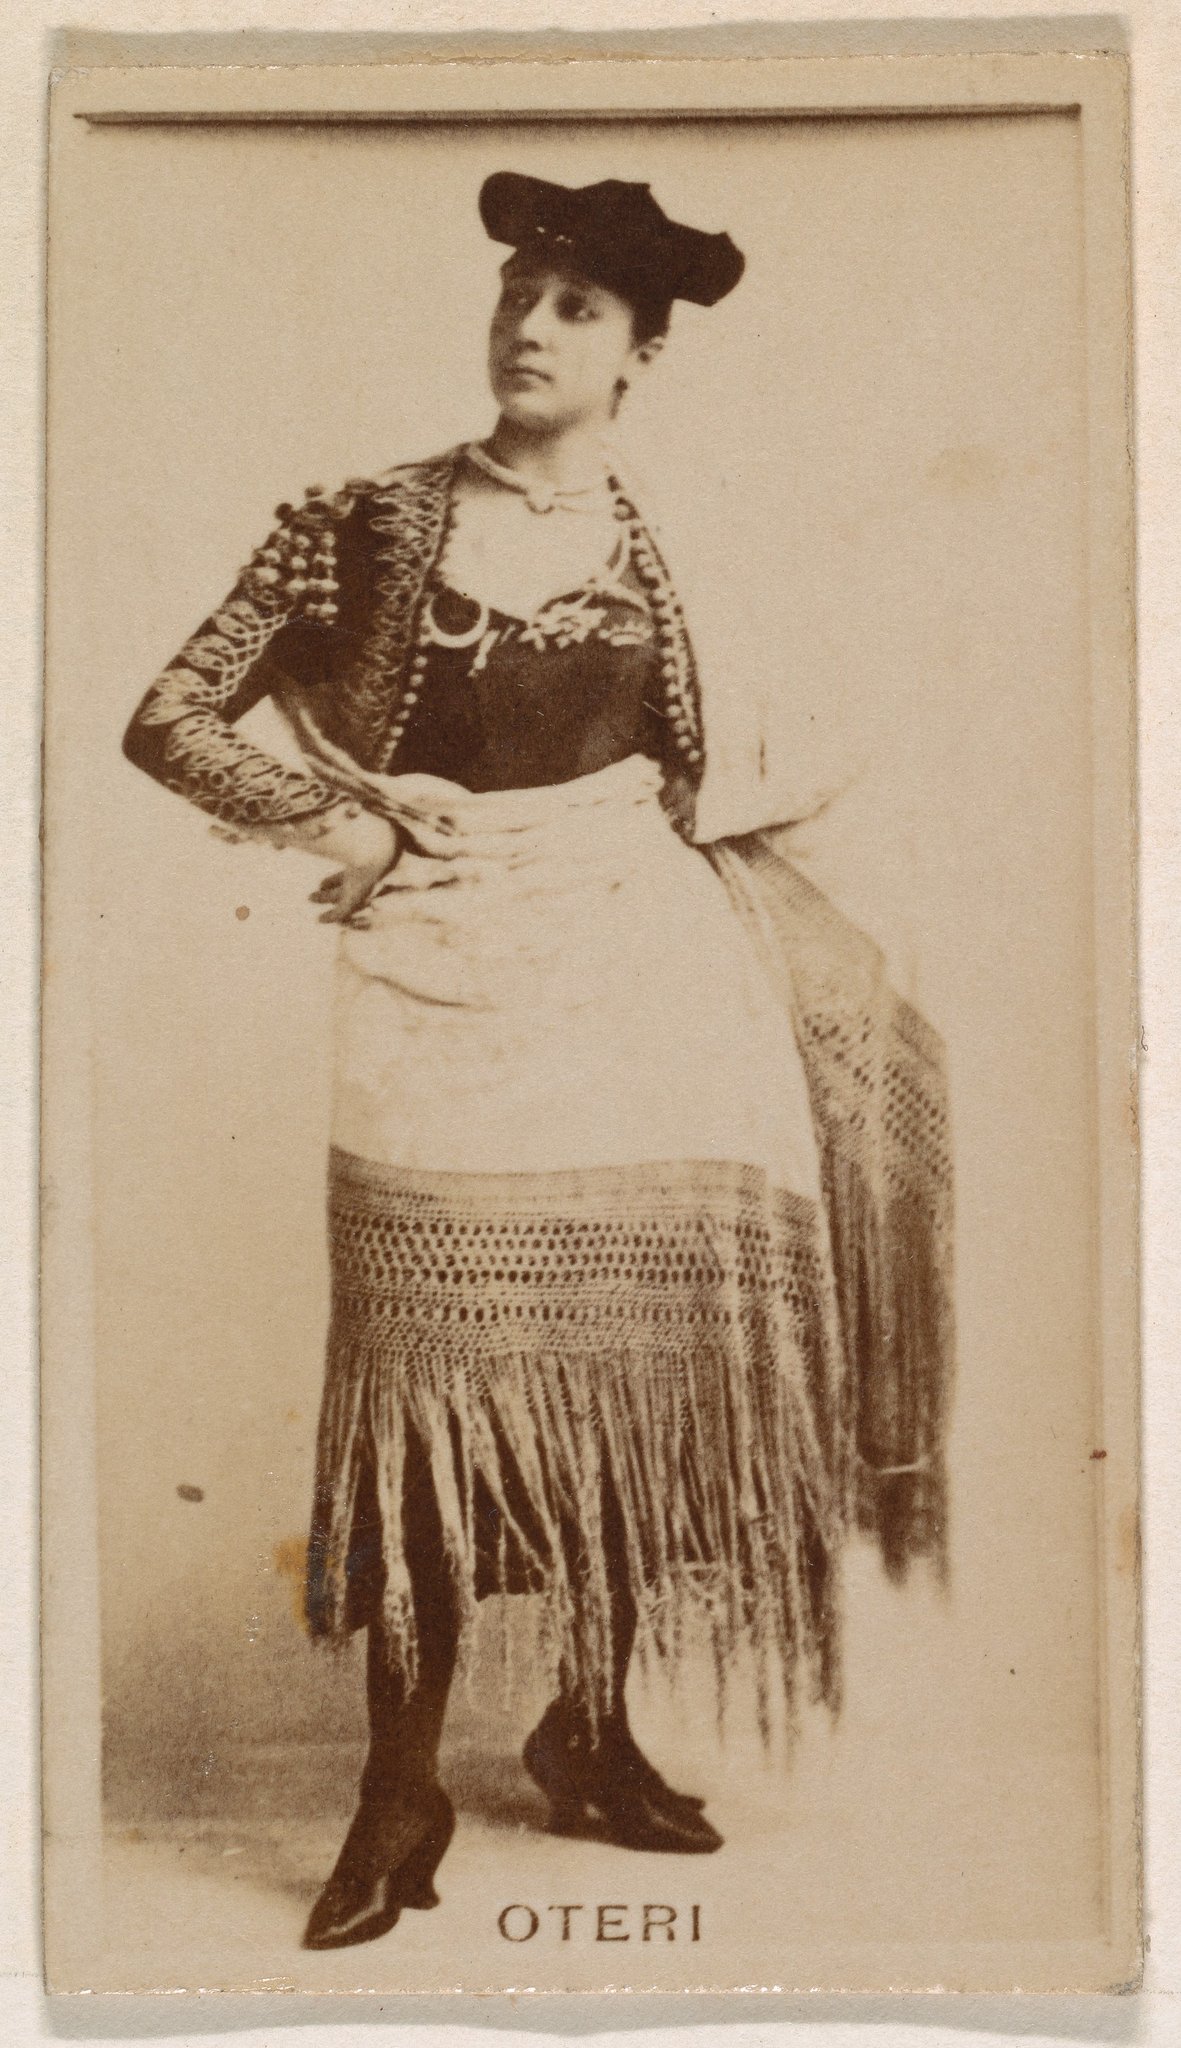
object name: photograph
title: Miss Oteri, from the Actresses series (N245) issued by Kinney Brothers to promote Sweet Caporal Cigarettes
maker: kinney brothers tobacco company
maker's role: publisher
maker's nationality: american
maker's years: 1869-2011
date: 1890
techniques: albumen silver print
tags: portraits,women,actresses